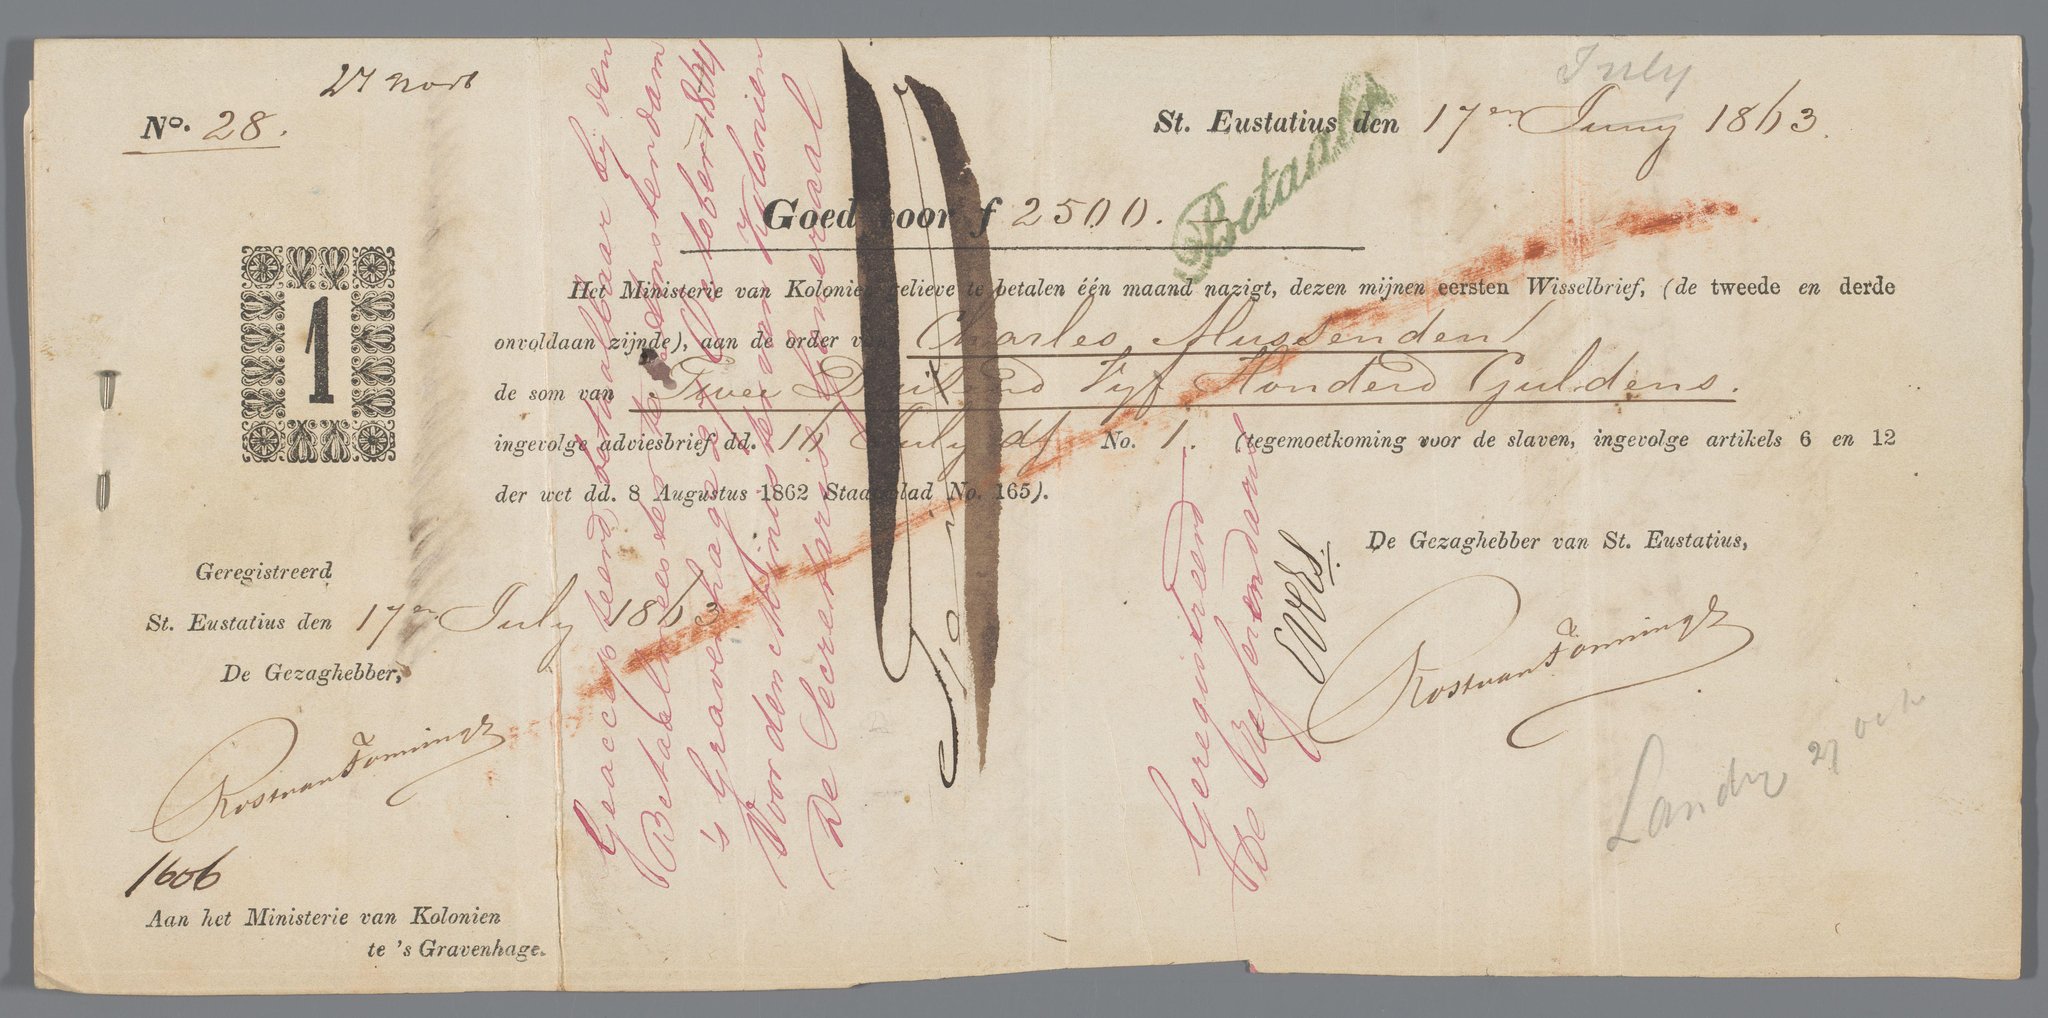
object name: ontvangstbewijs, kwitantie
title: Wisselbriefvoor Charles Hussenden, slavenhouder op Sint Eustatius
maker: Anonymous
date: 1863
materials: ink, paper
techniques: printing, writing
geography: netherlands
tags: slavery; serfs and enslaved persons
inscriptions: date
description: Wisselbrief ter waarde van 2500 gulden ten name van Charles Hussenden, 17 juli 1863. Wisselbrief uitgegeven aan slavenhouders op Sint Eustatius om deze bij de Emancipatie van 1863 te compenseren voor het vrij verklaren van de tot slaaf gemaakte mensen die zij tot hun bezit rekenden. Met twee aangehechte bladen.